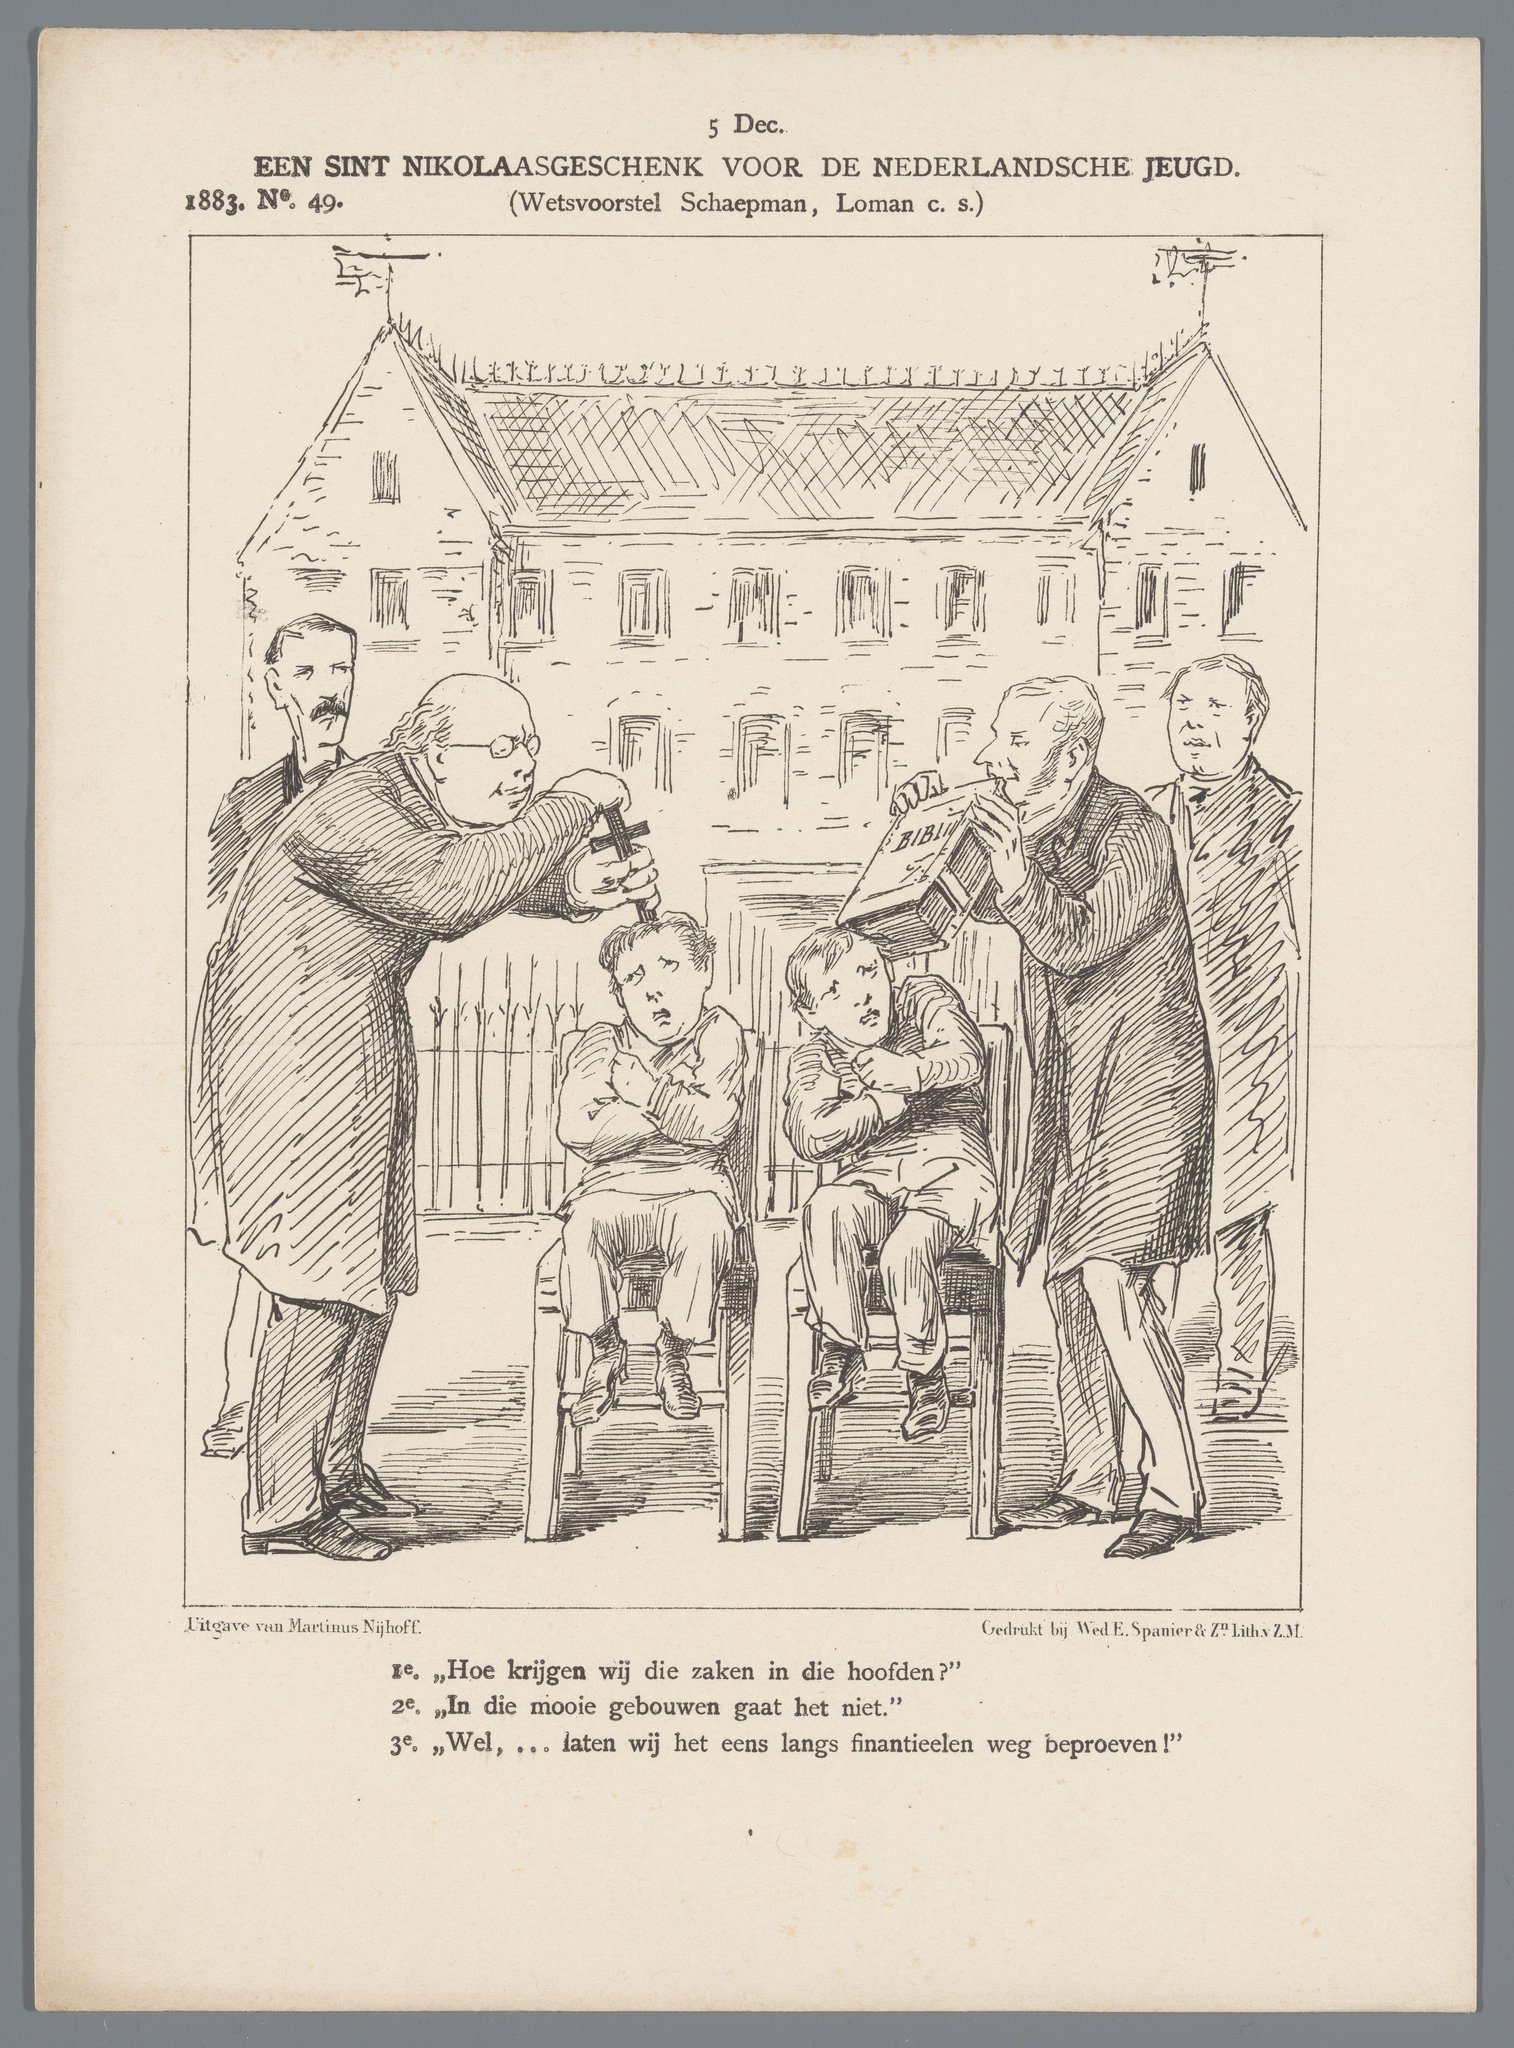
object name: print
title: 5 Dec. Een Sint Nikolaasgeschenk voor de Nederlandsche jeugd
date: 1883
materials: paper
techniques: lithograph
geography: netherlands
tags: rome, priest, herman johannes aloysius maria schaepman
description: Spotprent met Schaepman en Loman die een kruis en een Bijbel in de hoofden van kinderen proberen te krijgen. Plaat verschenen bij het weekblad De Nederlandsche Spectator, nr. 49, 1883.